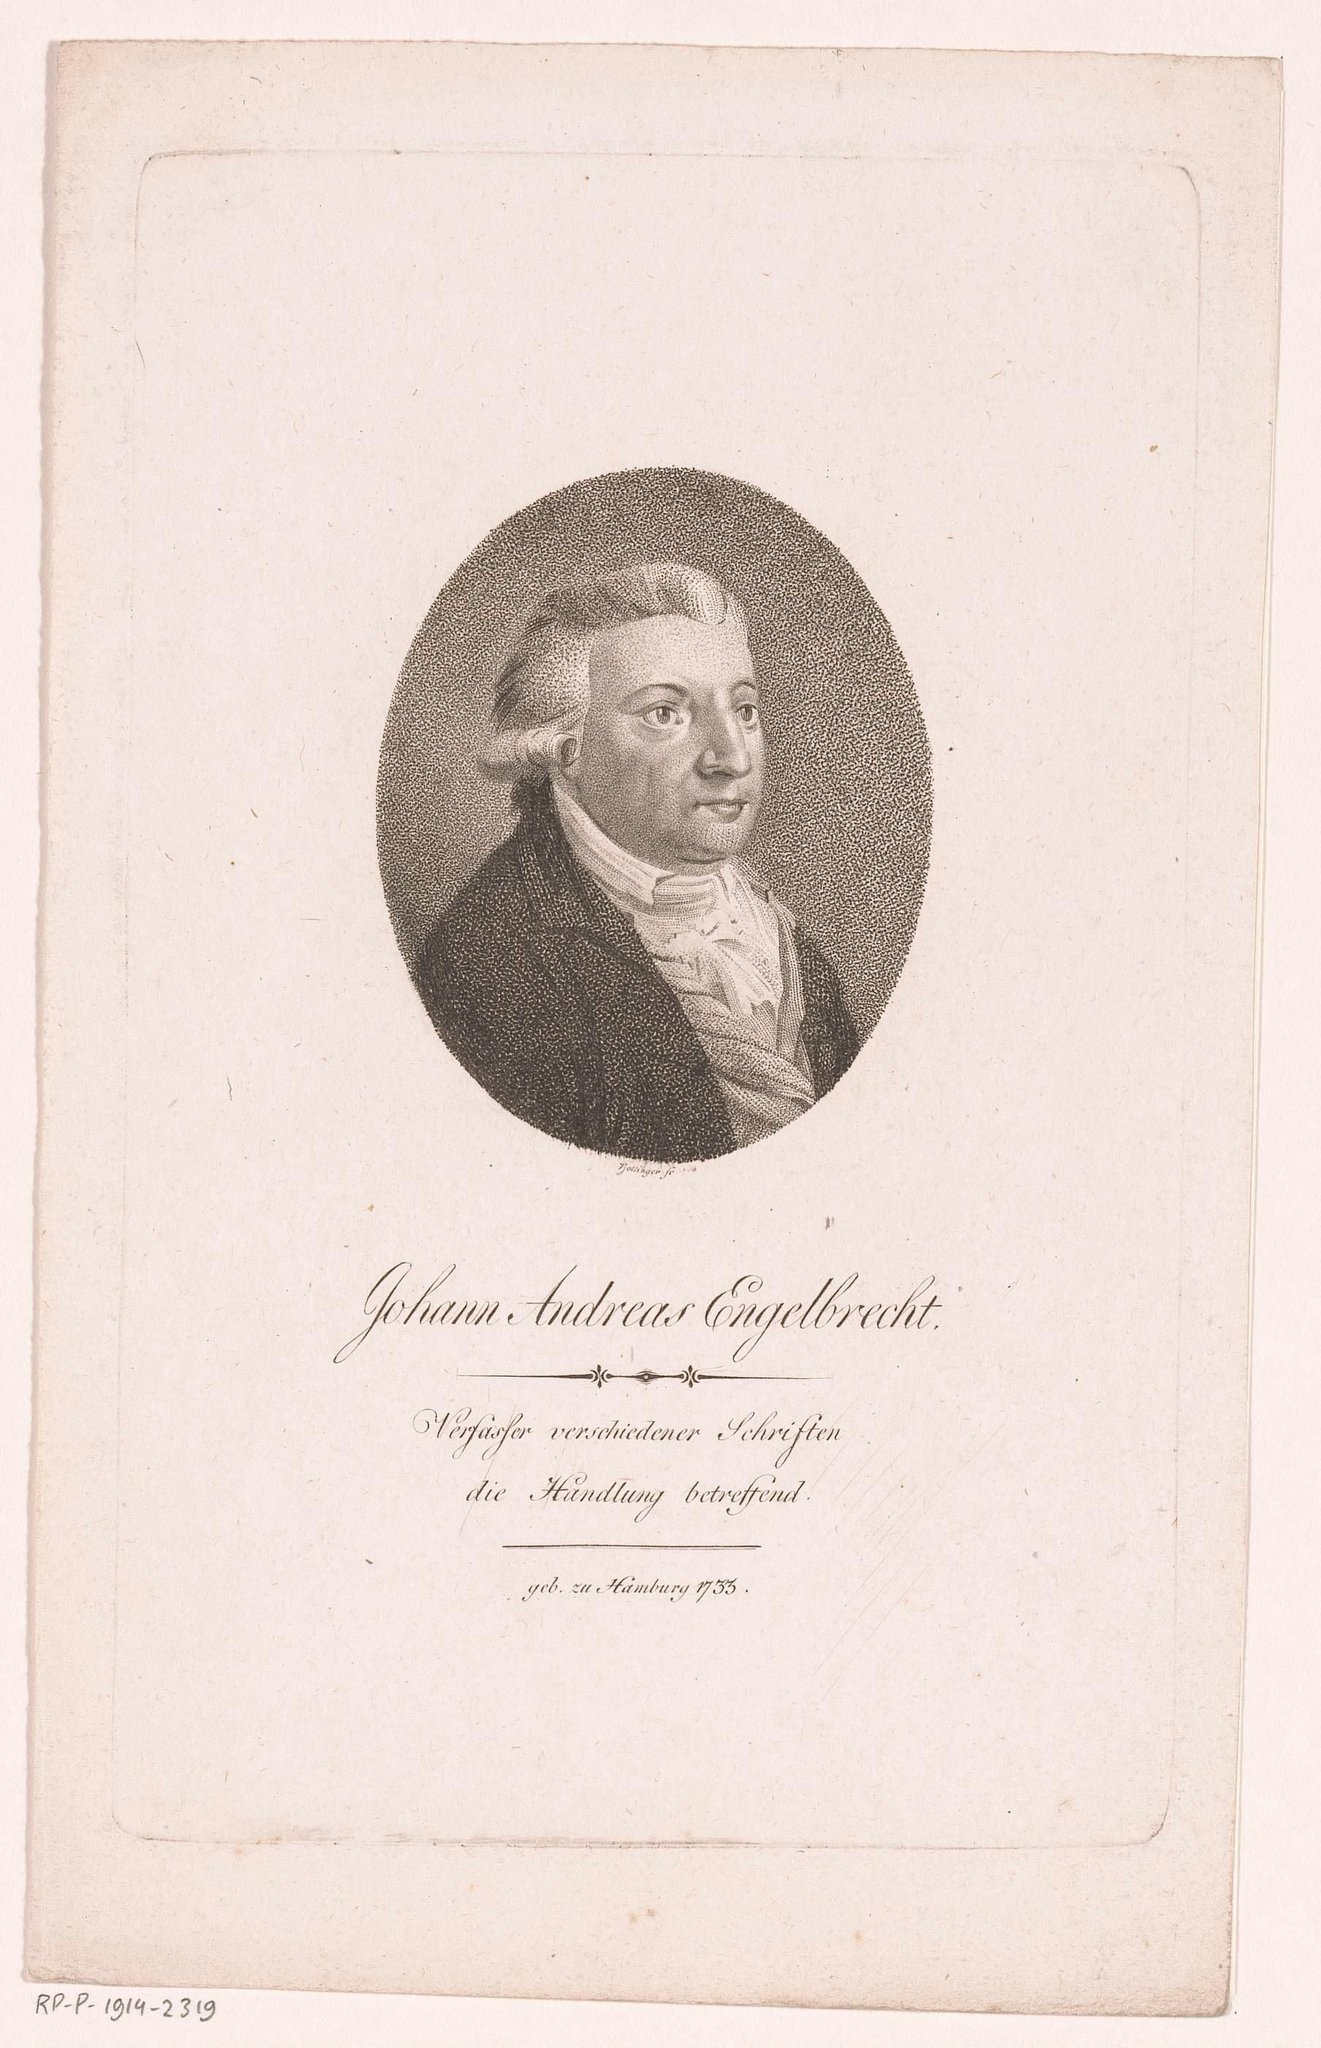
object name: print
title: Portret van Johann Andreas Engelbrecht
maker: friedrich wilhelm bollinger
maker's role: print maker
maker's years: 1777-1825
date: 1787-1825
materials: paper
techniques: engraving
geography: berlin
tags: historical persons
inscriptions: collector's mark: Lugt 2228